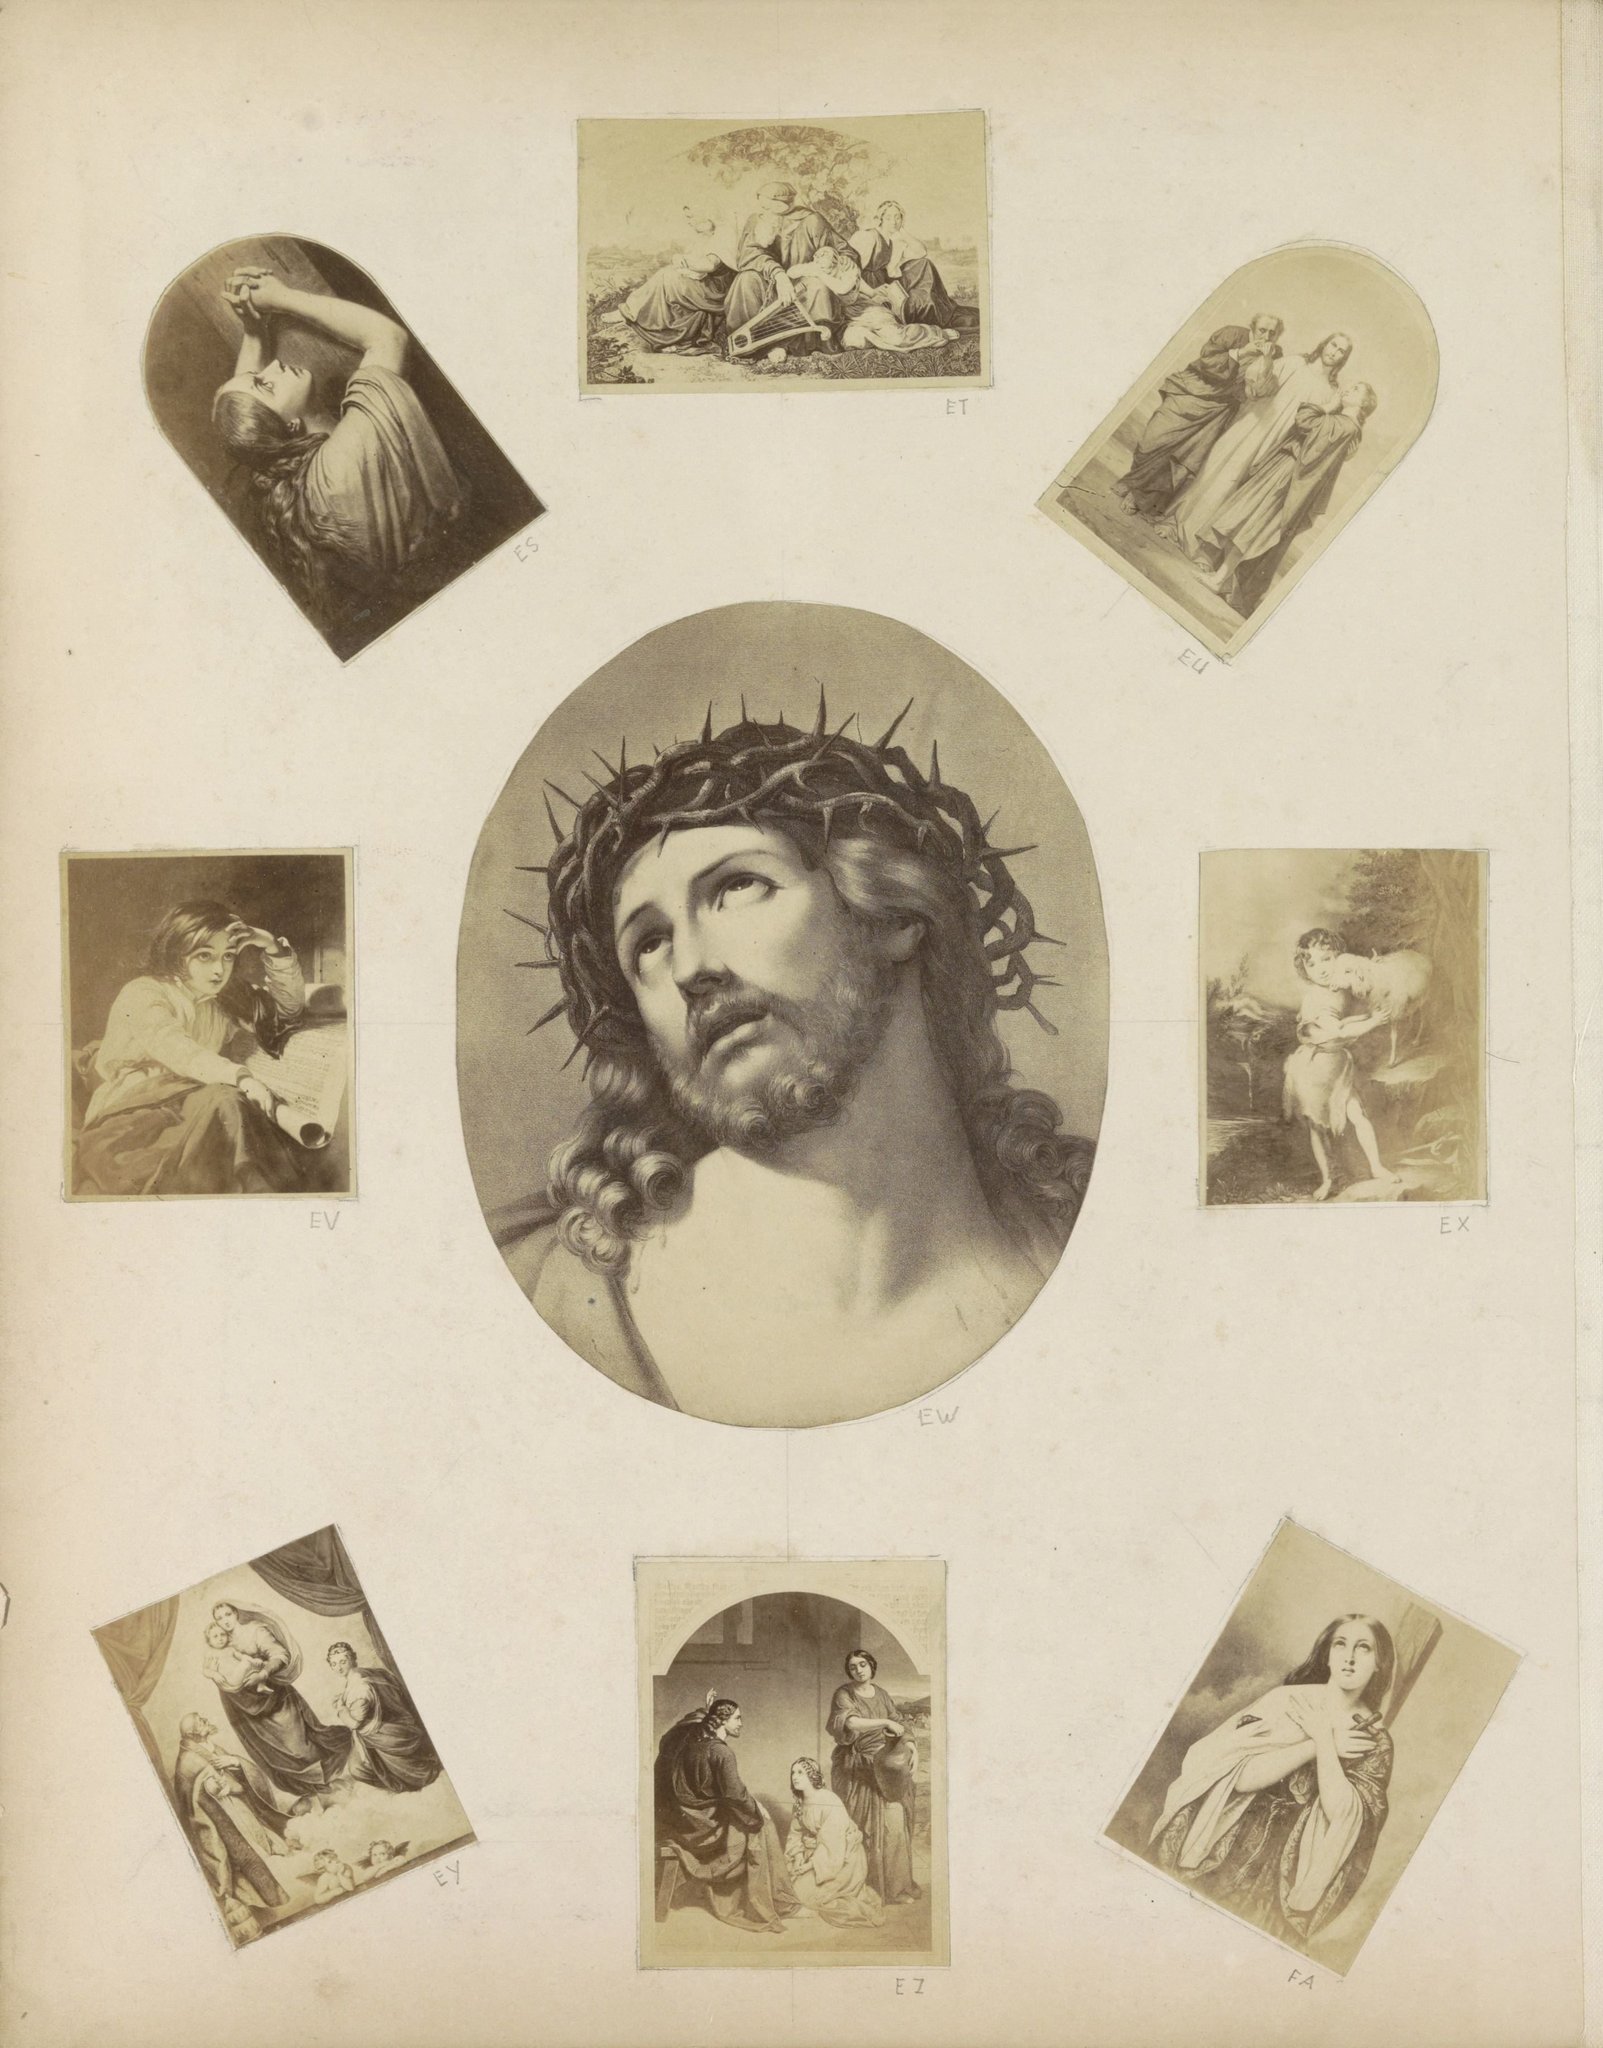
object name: photograph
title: Fotoreproductie van (vermoedelijk) een prent van een jongen zittend bij een tekstrol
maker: Anonymous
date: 1850-1870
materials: paper, photographic support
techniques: albumen print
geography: england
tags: child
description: Onderdeel van Album met foto's van bezienswaardigheden en landschappen in Engeland en van kunst.